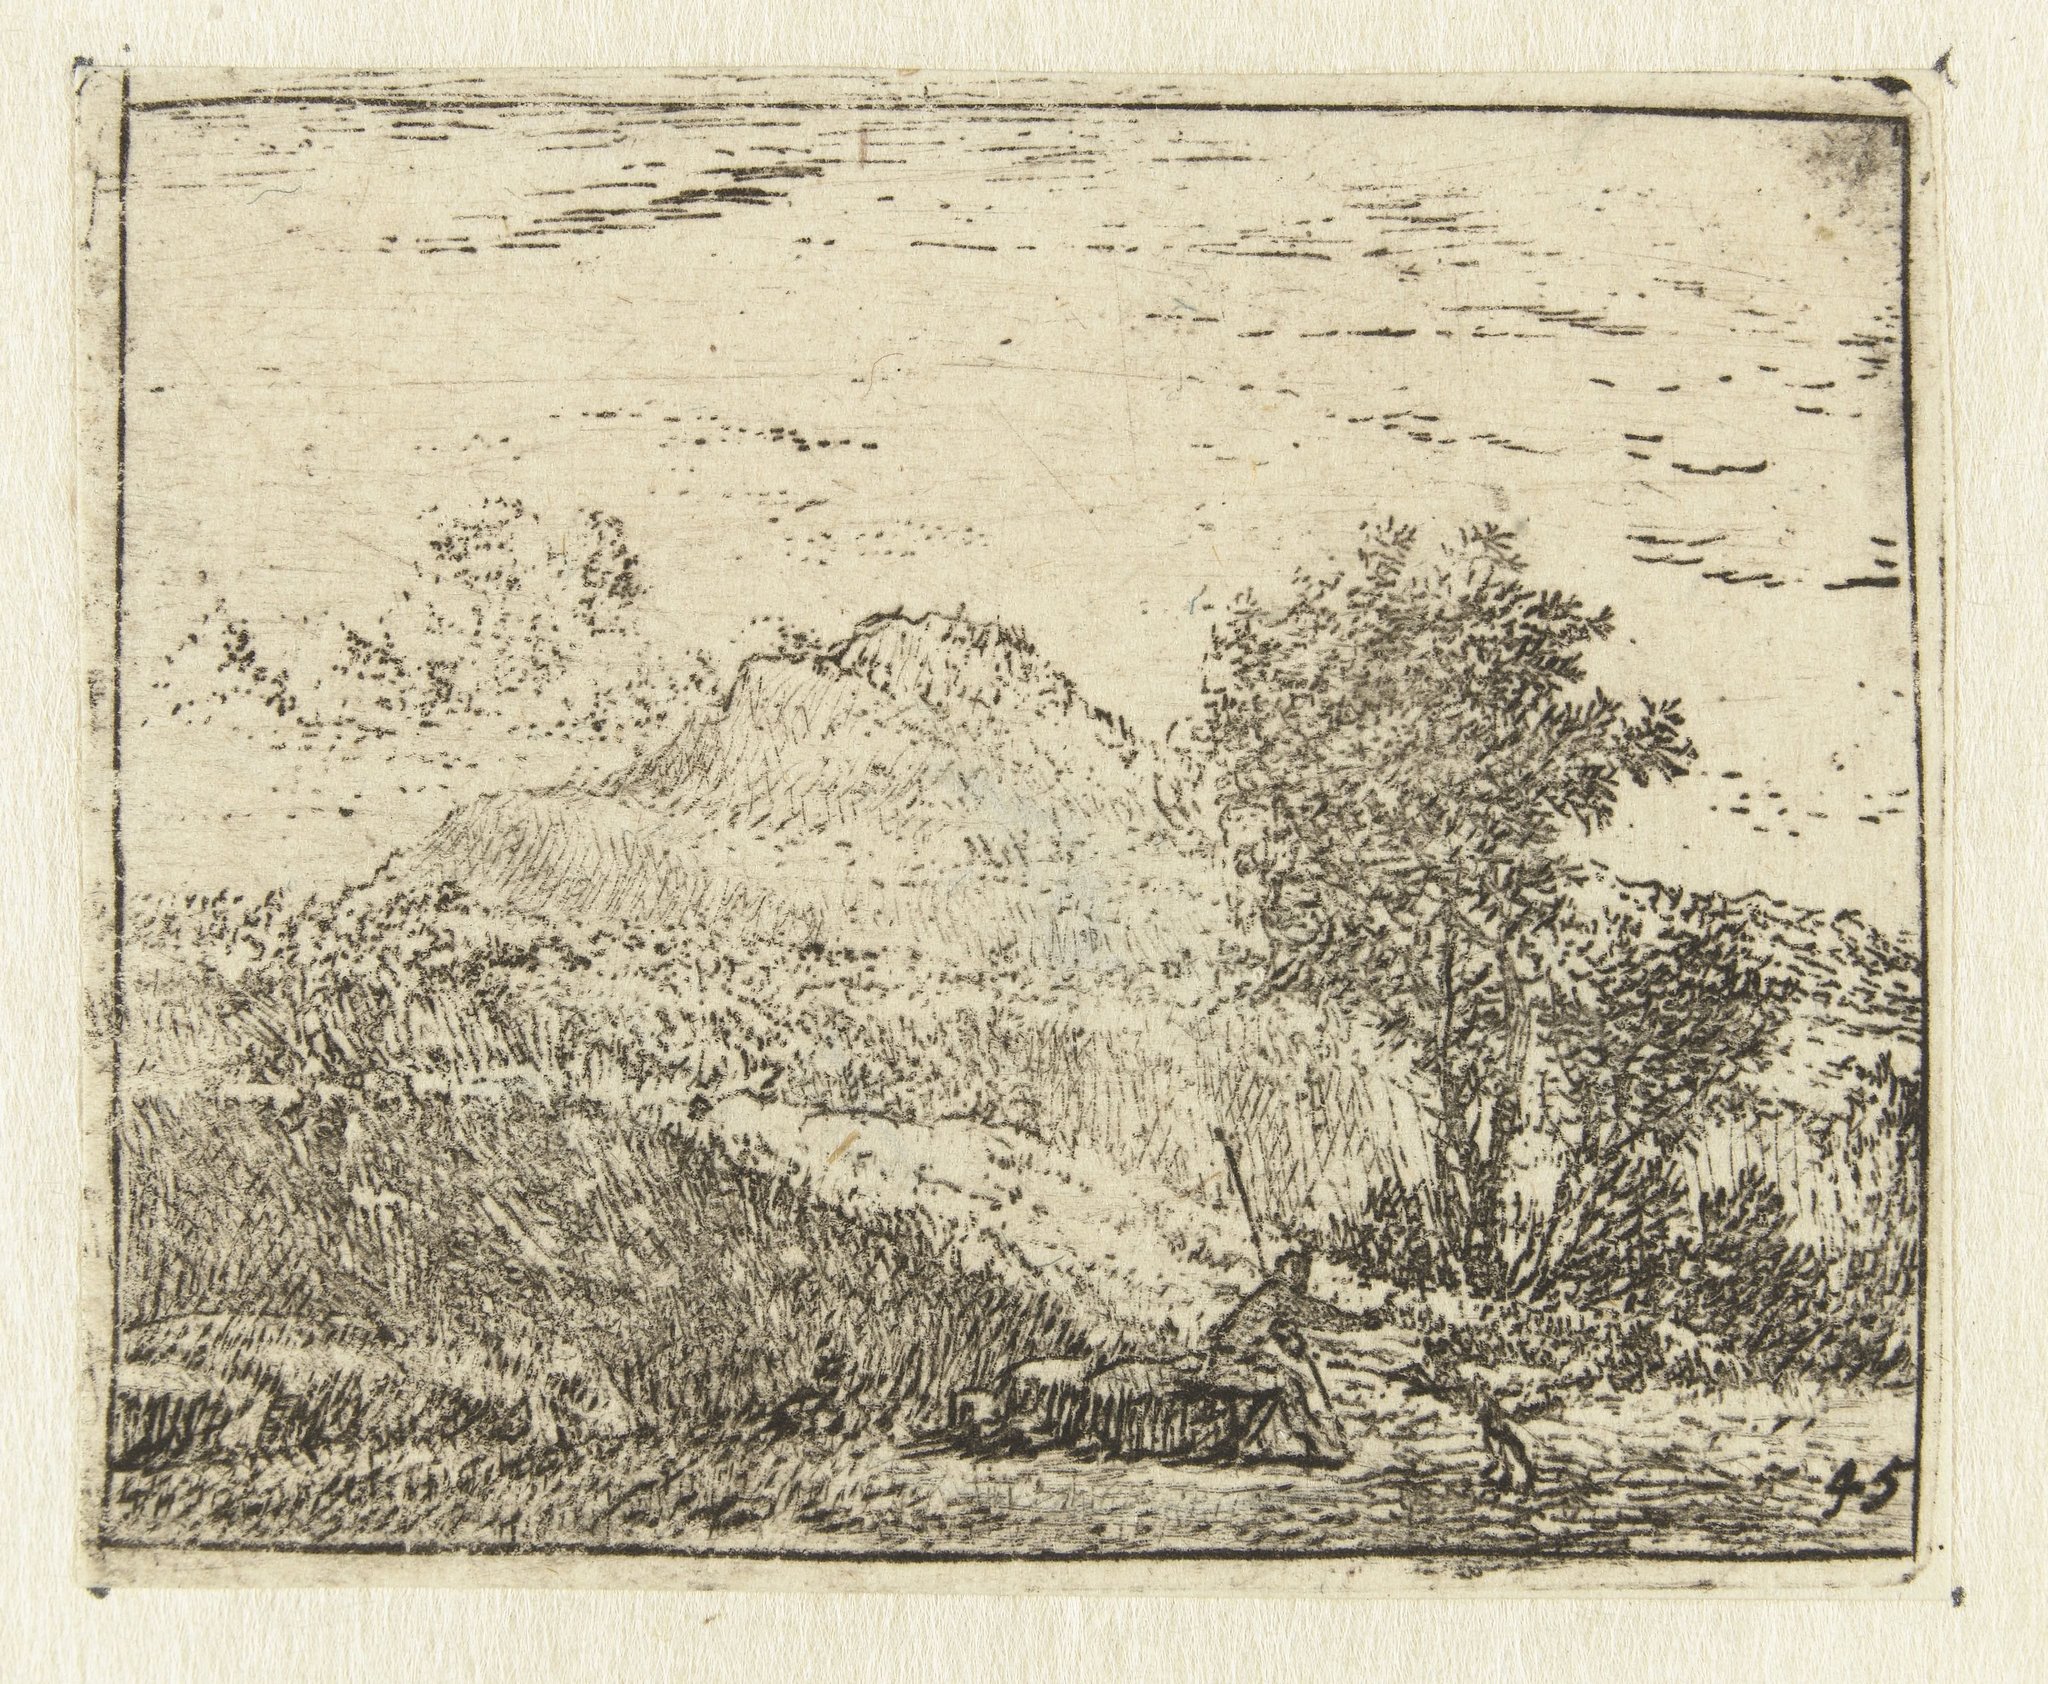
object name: print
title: Italianiserend landschap met herder en hond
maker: karel du jardin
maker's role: draughtsman, painter, print maker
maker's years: 1626-1678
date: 1652-1659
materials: paper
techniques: etching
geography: netherlands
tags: (high) hill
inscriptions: collector's mark: Lugt 2228a